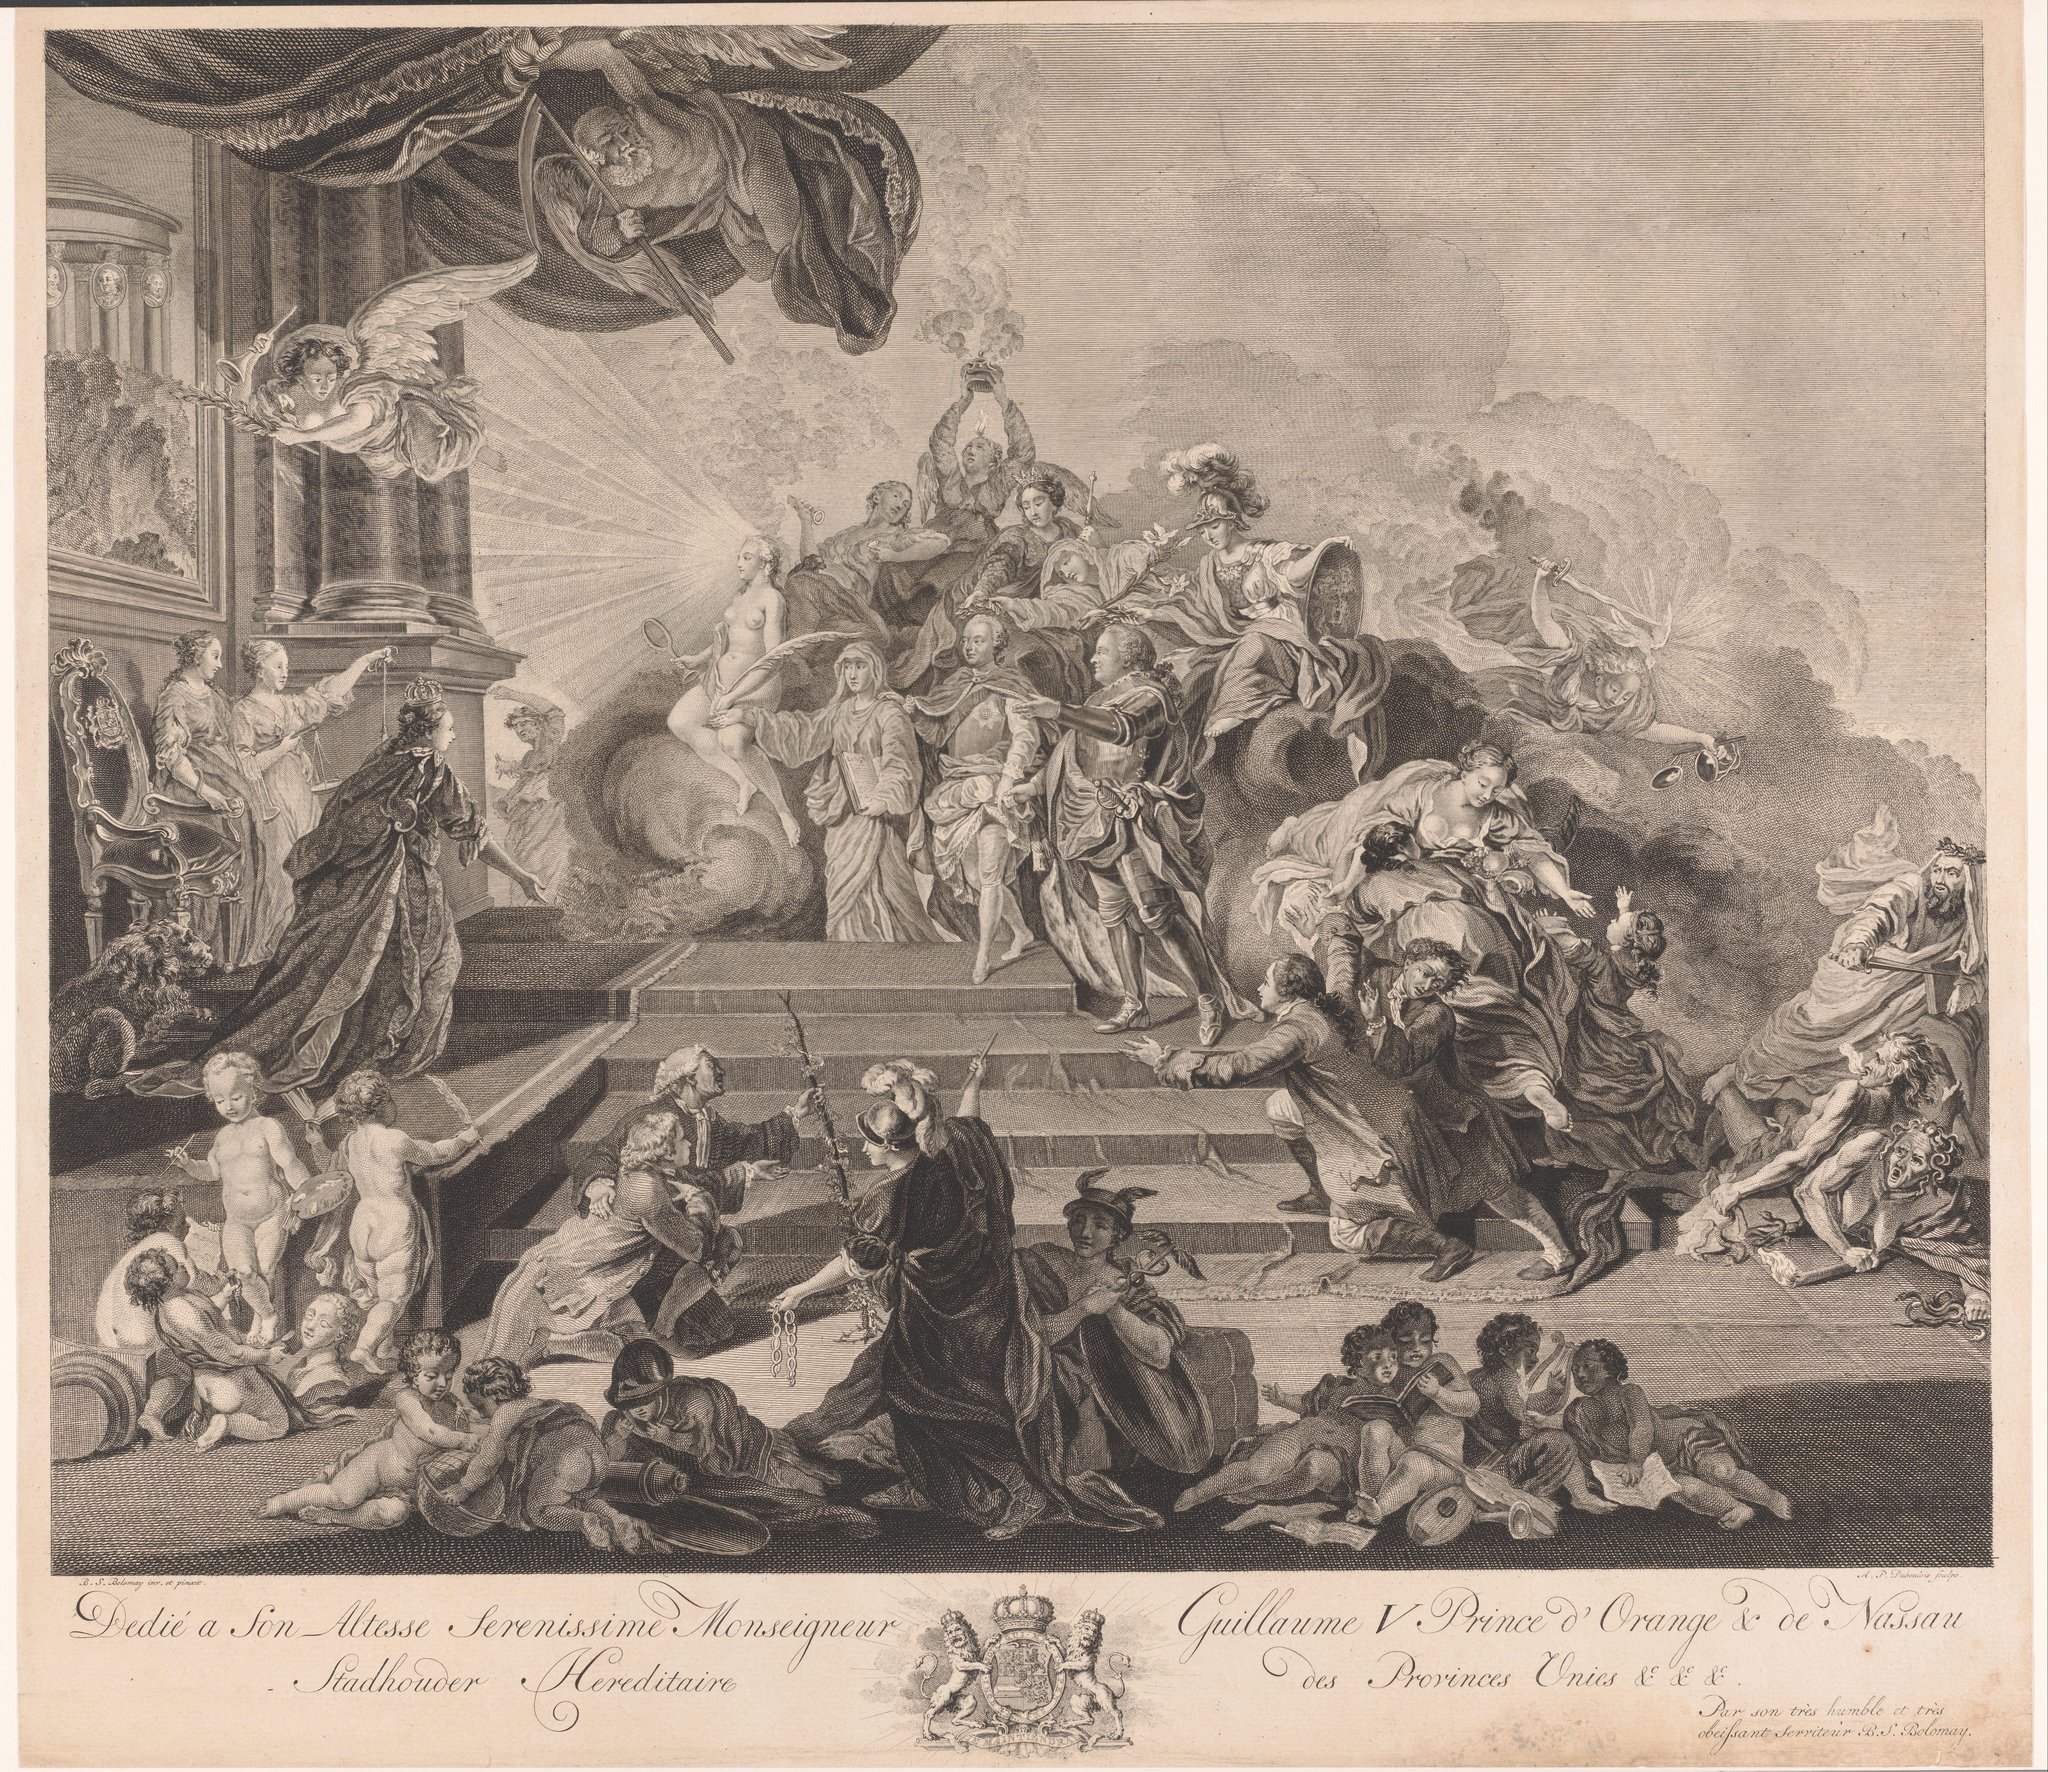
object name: print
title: Allegorie op de aanvaarding van het stadhouderschap door prins Willem V, 1766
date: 1766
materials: paper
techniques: engraving, etching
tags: the hague, william v (prince of orange), ludwig ernst von braunschweig-wolfenbüttel, historical persons, ruler, sovereign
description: Allegorie op de aanvaarding van het stadhouderschap door prins Willem V bij zijn meerderjarigheid op 8 maart 1766. De prins wordt door zijn mentor, de hertog van Brunswijk, naar de zetel van het stadhouderschap geleid. De prins wordt vergezeld door de Vroomheid en de Waarheid, bij de troon wachten Rechtvaardigheid, Voorzichtigheid en de Nederlandse Maagd. Rechts verjaagt de Engel Gods de Tweedracht, Fanatisme en Ketterij. Op de voorgrond spelen geniën met de symbolen van kunsten en wetenschappen. Bij de prent behoort een tekstblad met uitleg (zie RP-P-OB-85.628A).